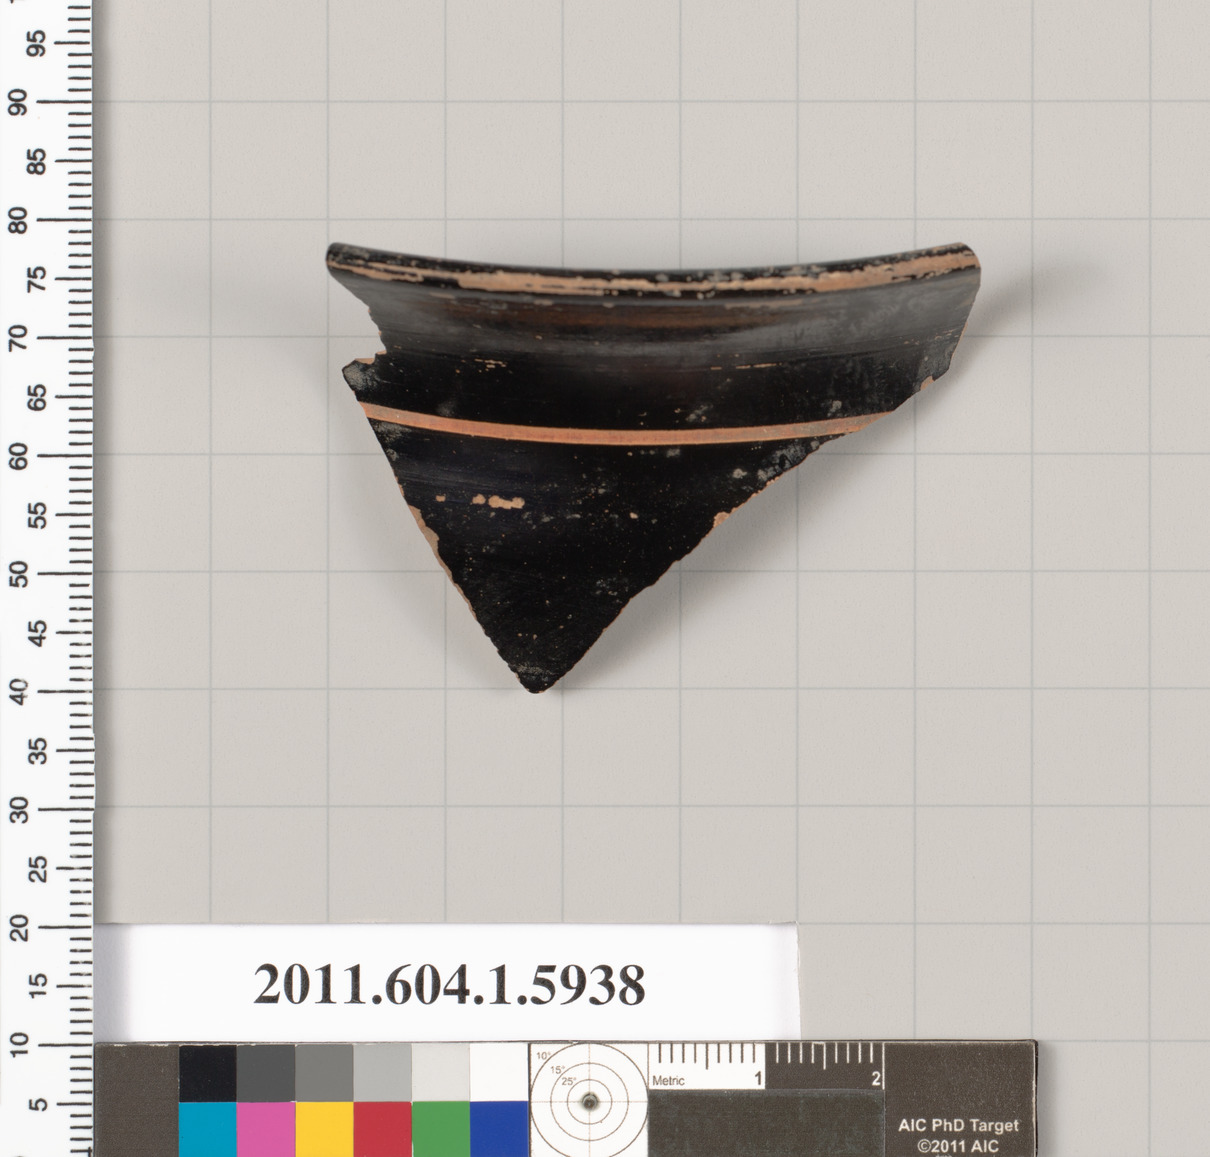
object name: mastoid fragment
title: Terracotta fragment of a mastoid?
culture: greek, attic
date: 520-510 BCE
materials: terracotta